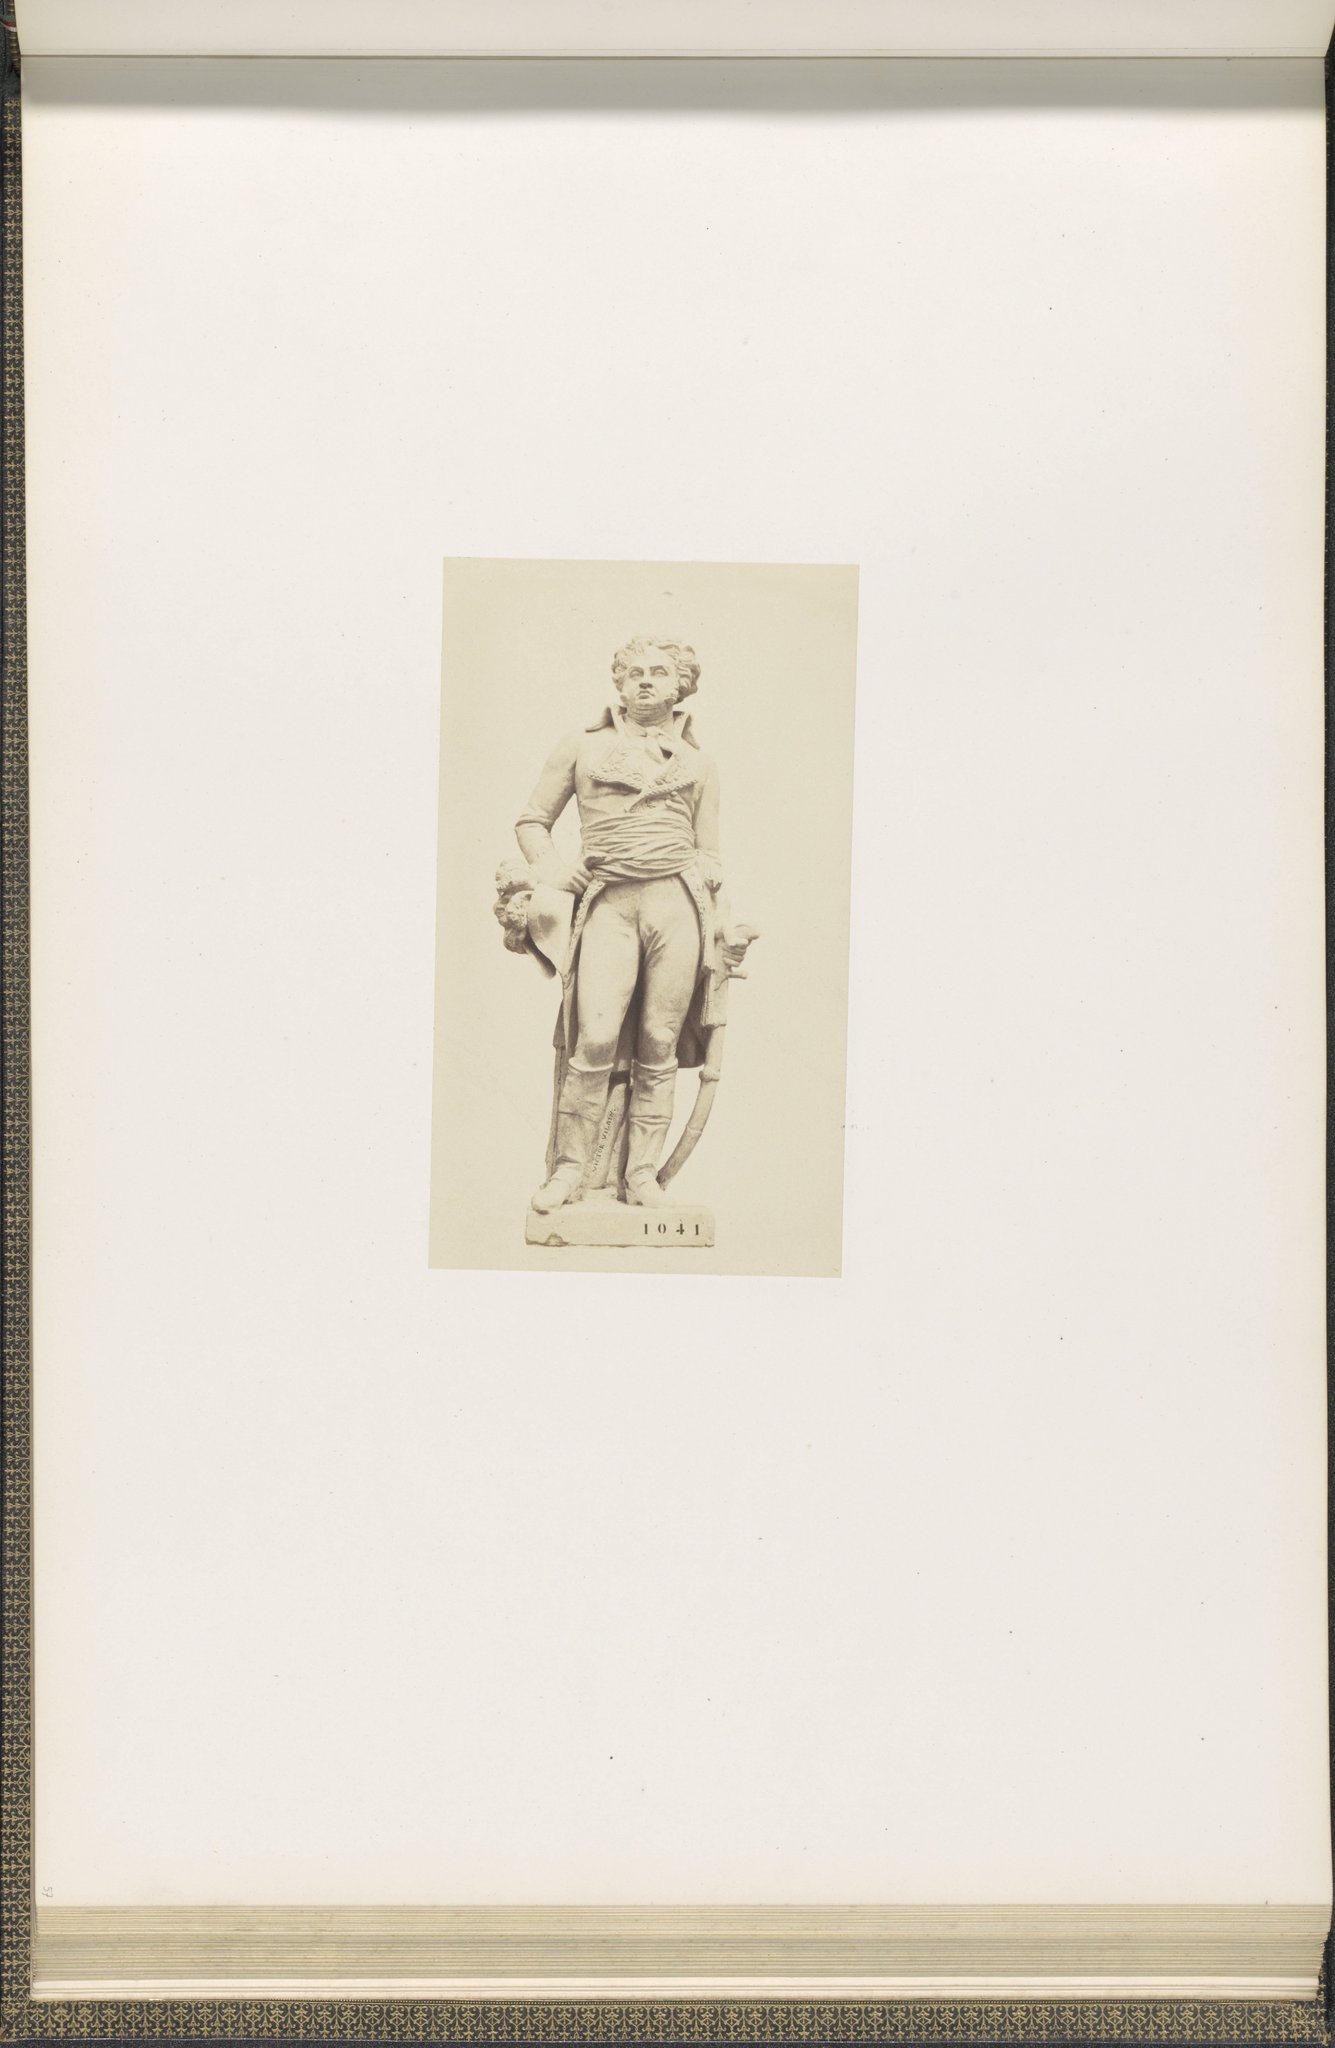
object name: album leaf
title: Gipsmodel voor beeldhouwwerk op het Palais du Louvre: "Kléber" door Victor Vilain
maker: édouard denis baldus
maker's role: fotograaf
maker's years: 1813-1889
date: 1855-1857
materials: paper, photographic support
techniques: salted paper print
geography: paris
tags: piece of sculpture, reproduction of a piece of sculpture, permanent exhibition, museum, paris, tuileries palace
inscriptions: number: ‘1041’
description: Onderdeel van Réunion des Tuileries au Louvre 1852-1857, album 4.